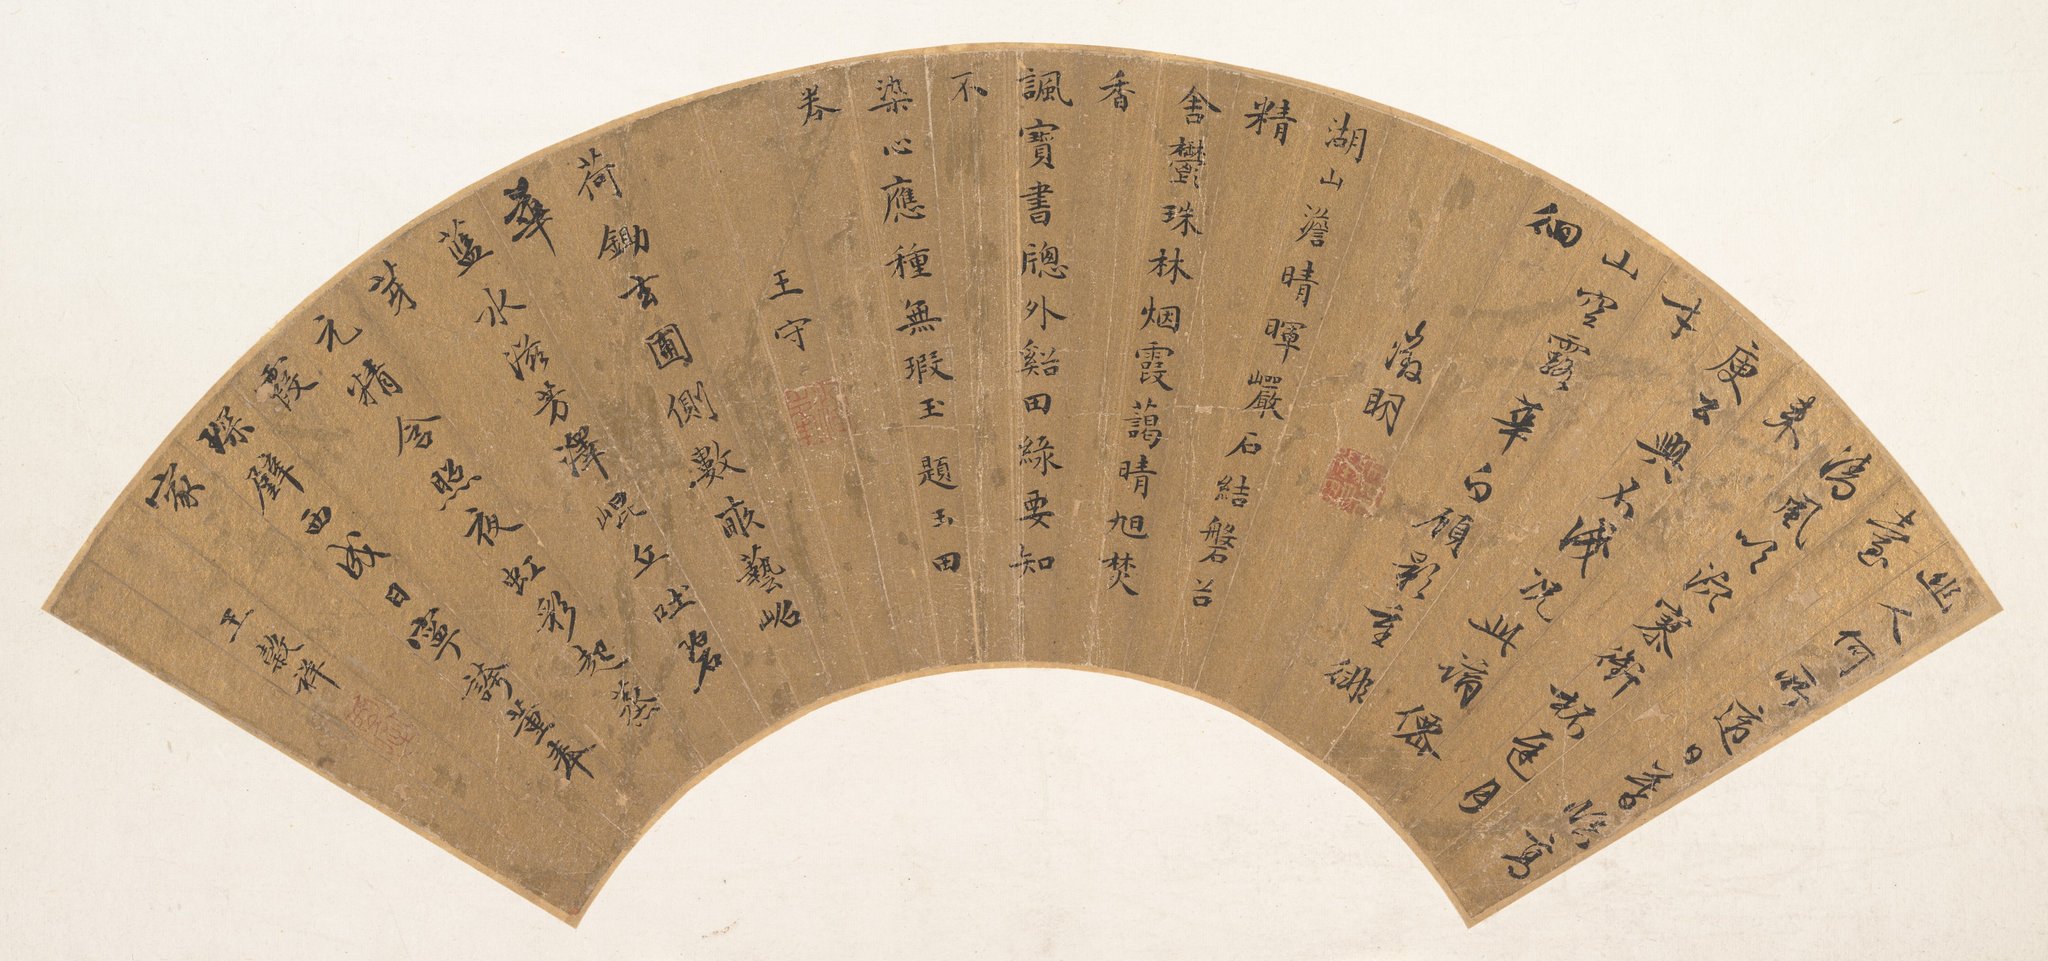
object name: folding fan mounted a an album leaf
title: Three Poems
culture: chinese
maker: wen zhengming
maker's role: artist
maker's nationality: chinese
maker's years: 1470-1559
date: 1470-1559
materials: gold, ink, paper